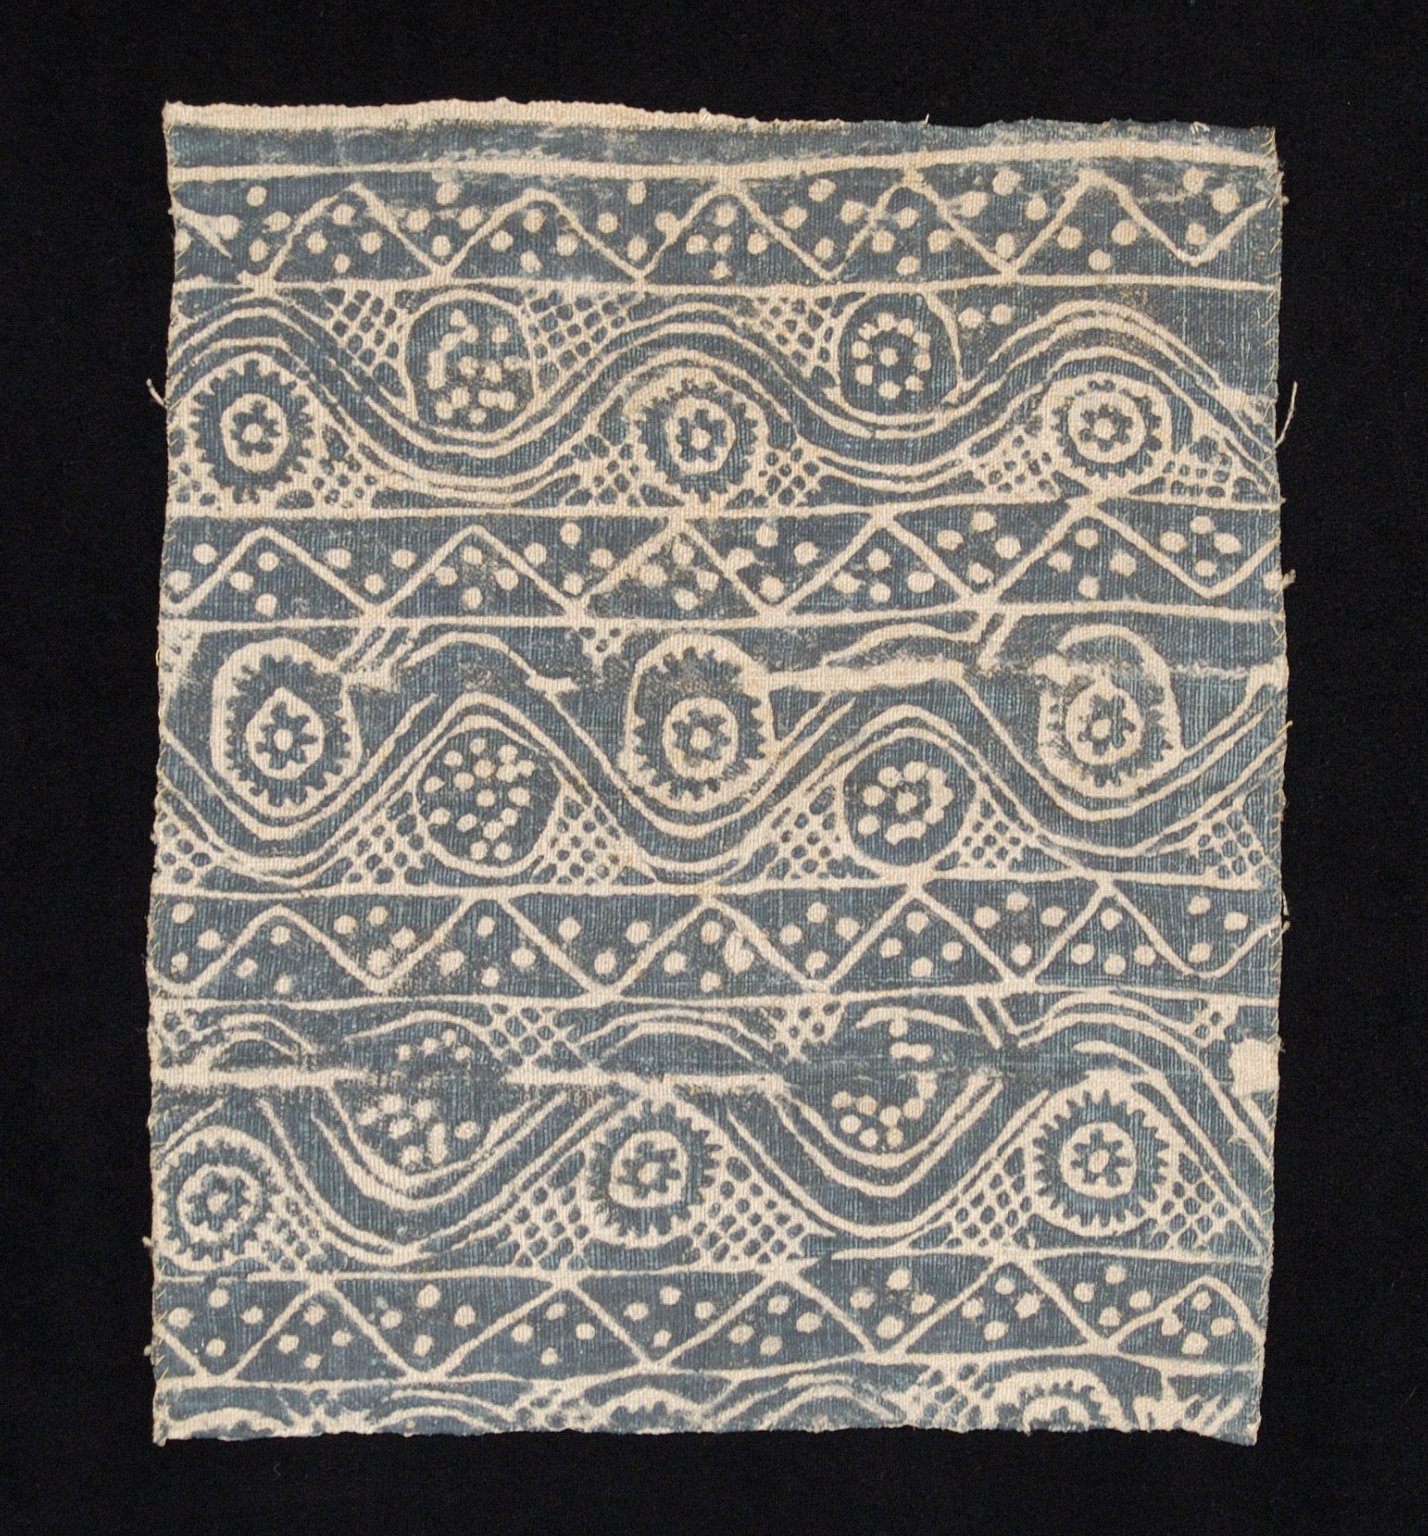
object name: textile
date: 1700-1899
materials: linen